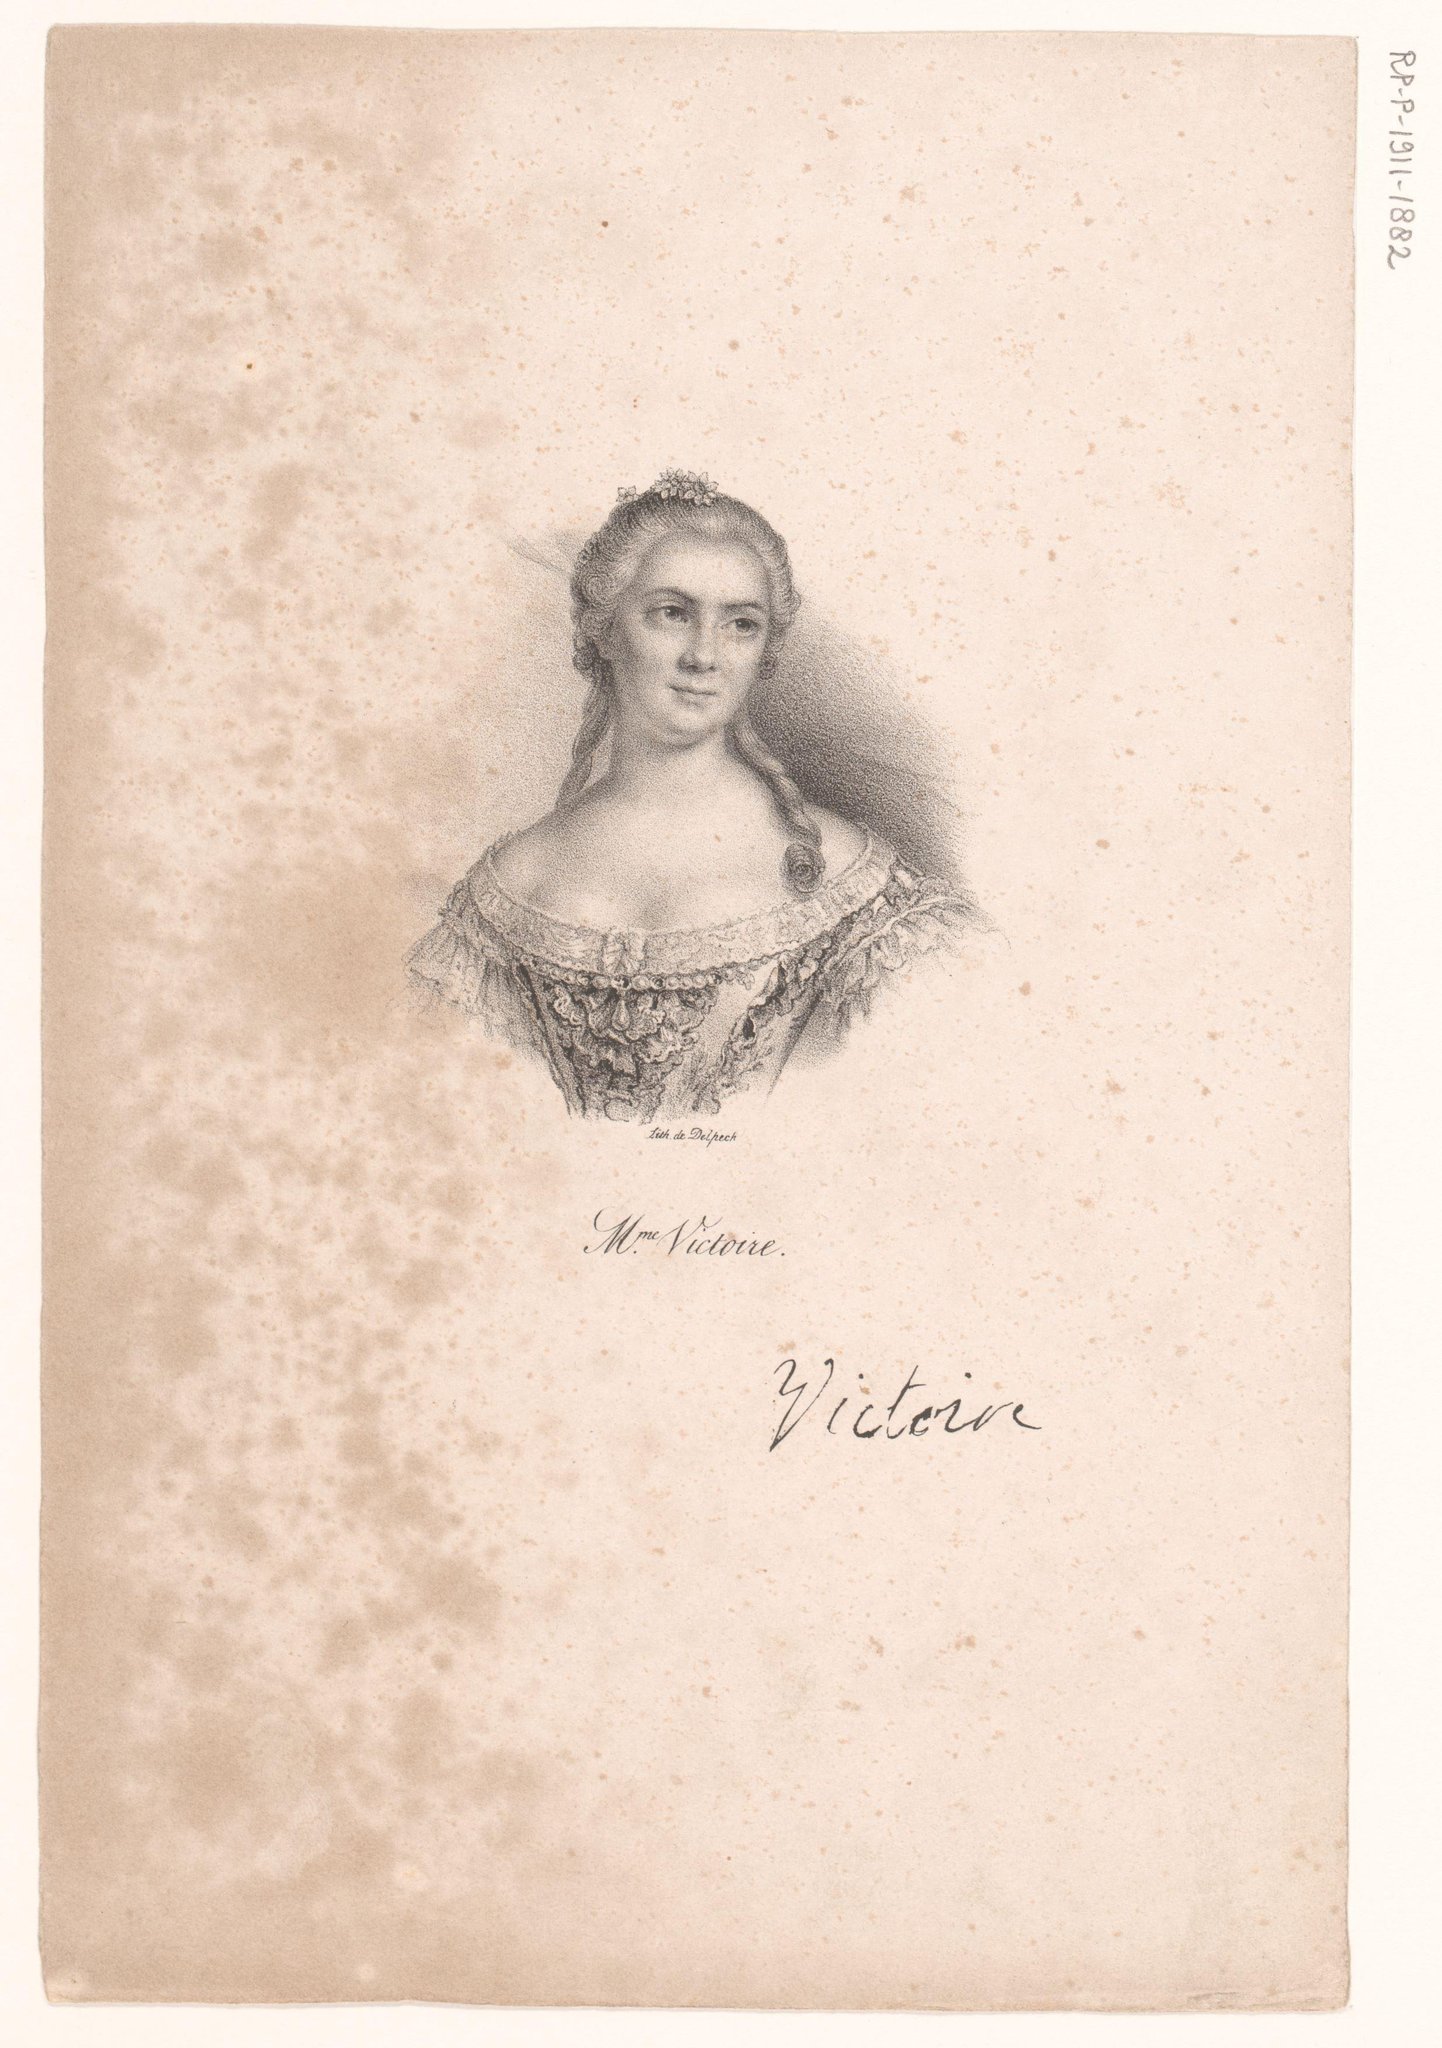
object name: print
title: M.me Victoire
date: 1818-1842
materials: paper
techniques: lithograph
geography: paris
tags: historical persons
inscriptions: collector's mark: Lugt 2228a